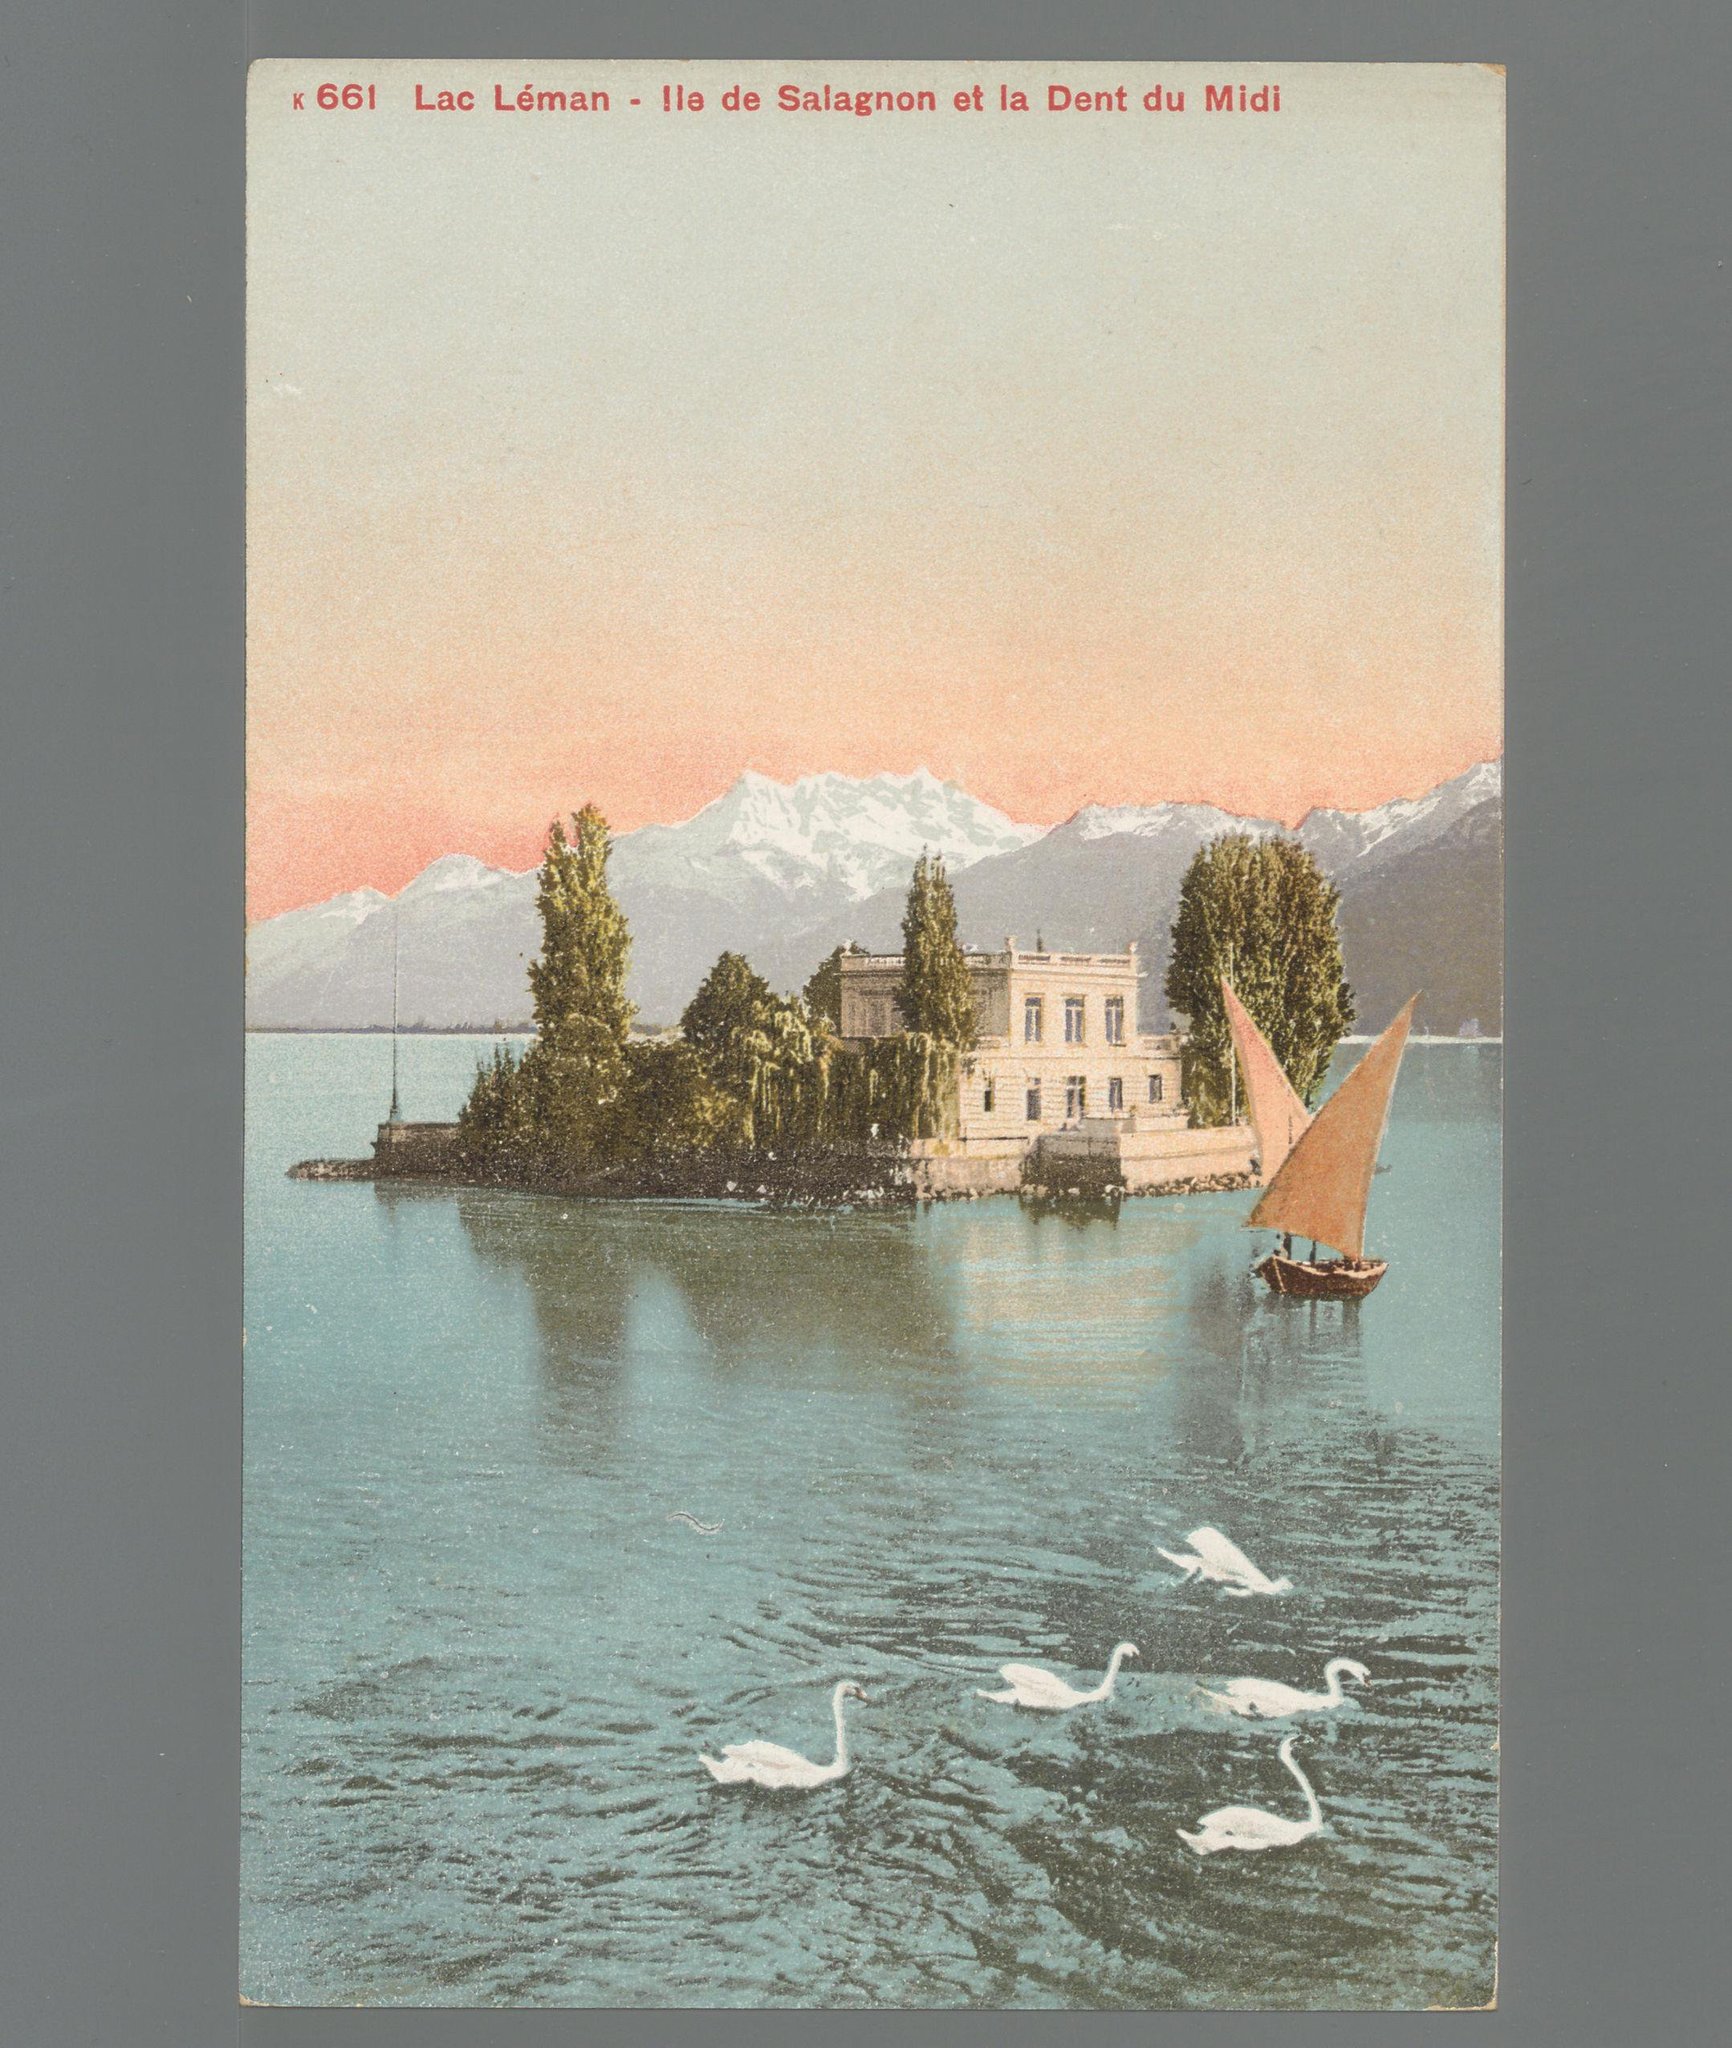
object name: ansichtkaart, prentbriefkaart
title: Lac Léman. Ile de Salagnon et la Dent du Midi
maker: Anonymous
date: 1905-1930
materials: cardboard, photographic process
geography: lake geneva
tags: island, lake, mountain-range, snow peaks